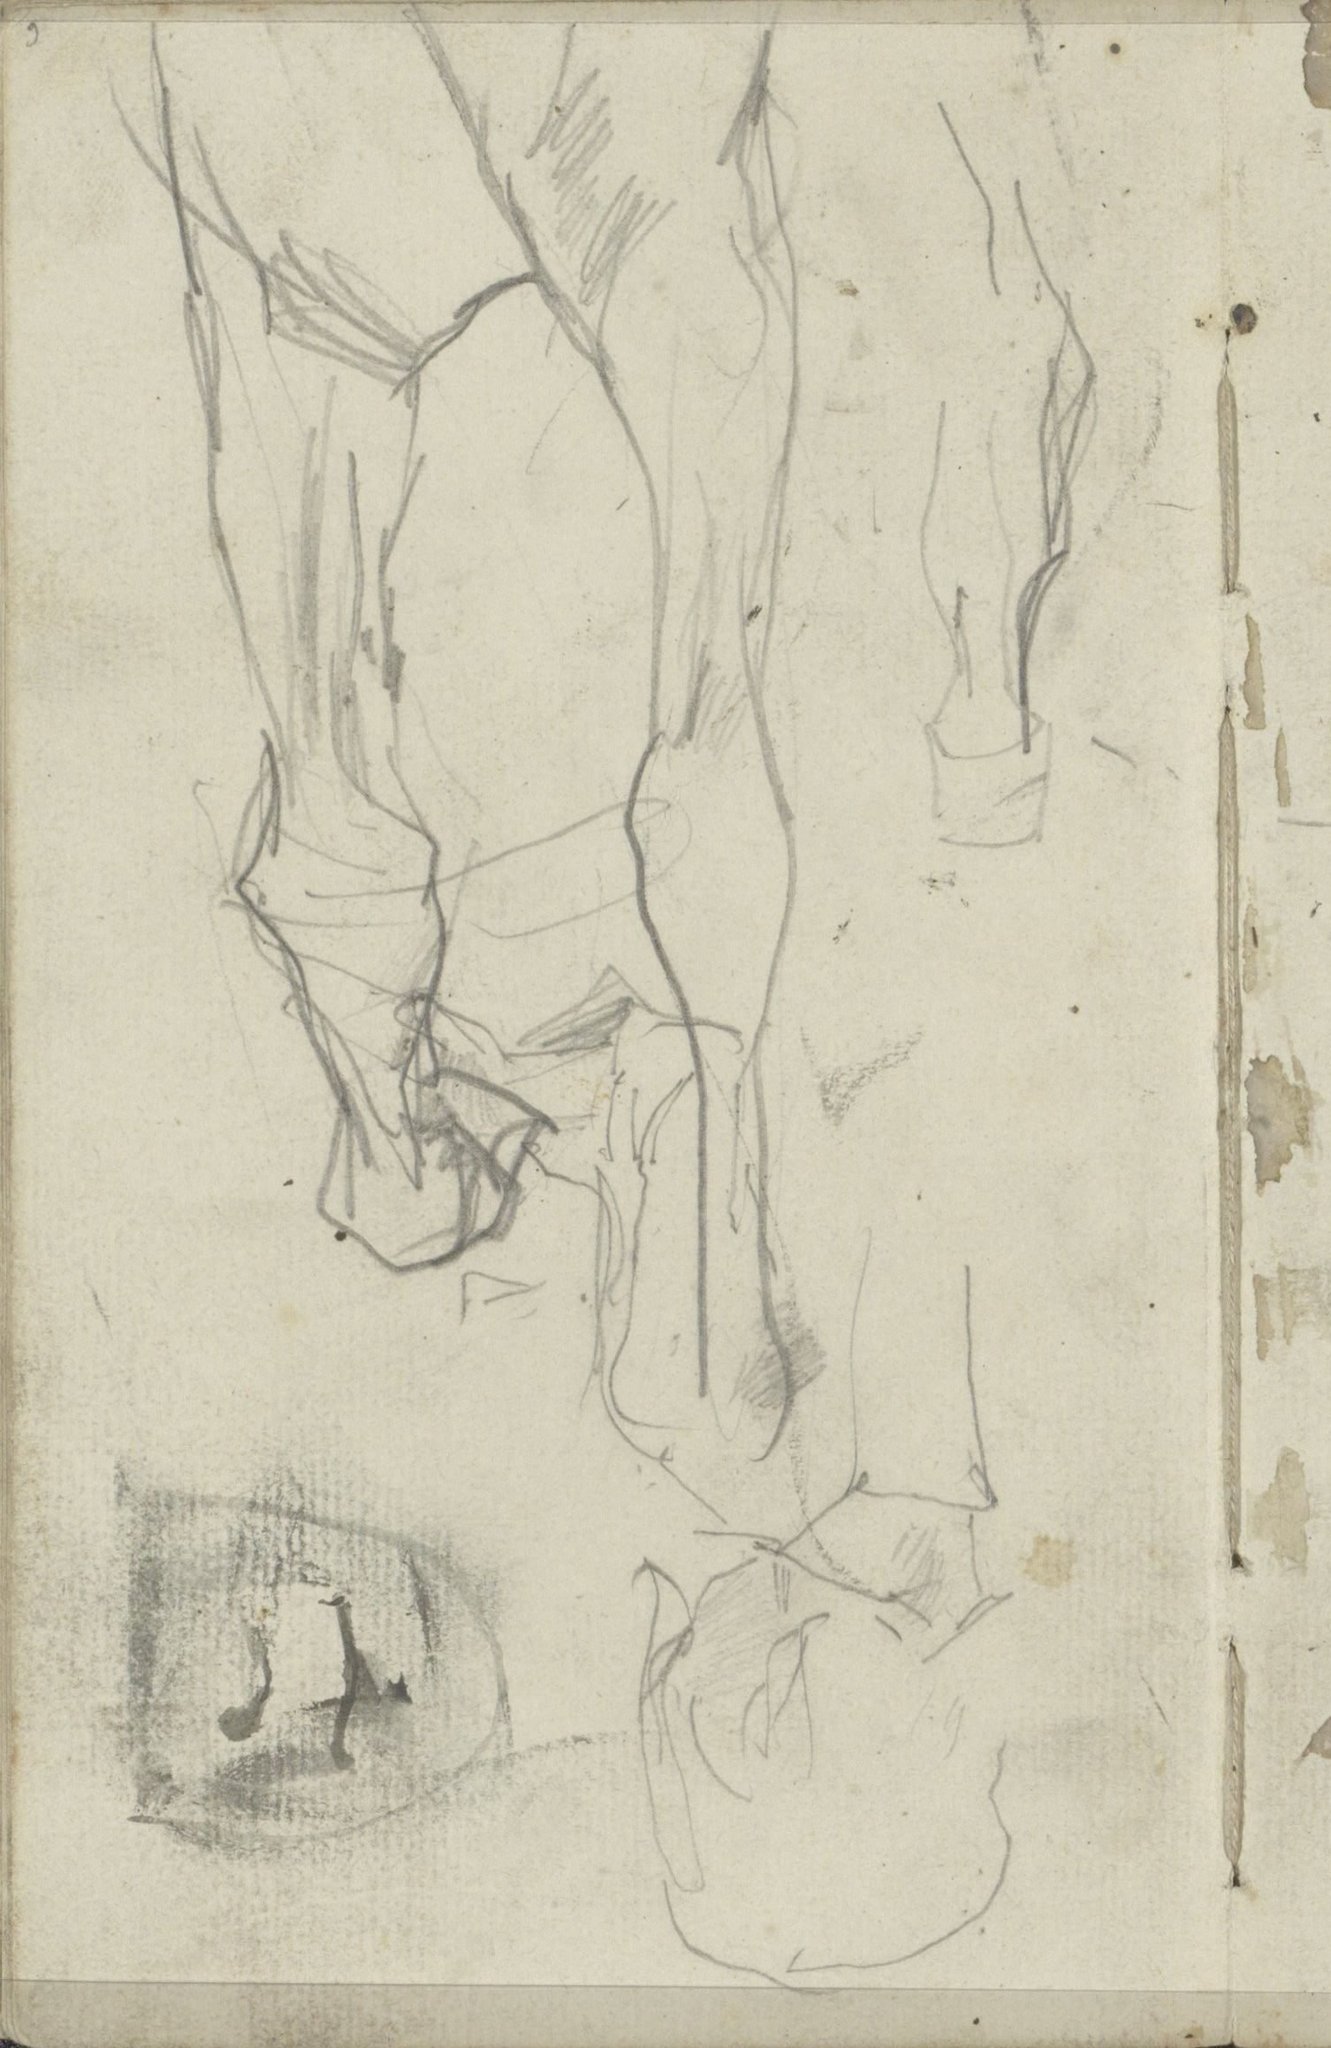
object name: sketchbook leaf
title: Paardenbenen en een figuurstudie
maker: george hendrik breitner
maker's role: draughtsman, painter, print maker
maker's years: 1857-1923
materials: paper, pencil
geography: the hague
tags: child, horse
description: Pagina 9 uit een schetsboek met 28 bladen.